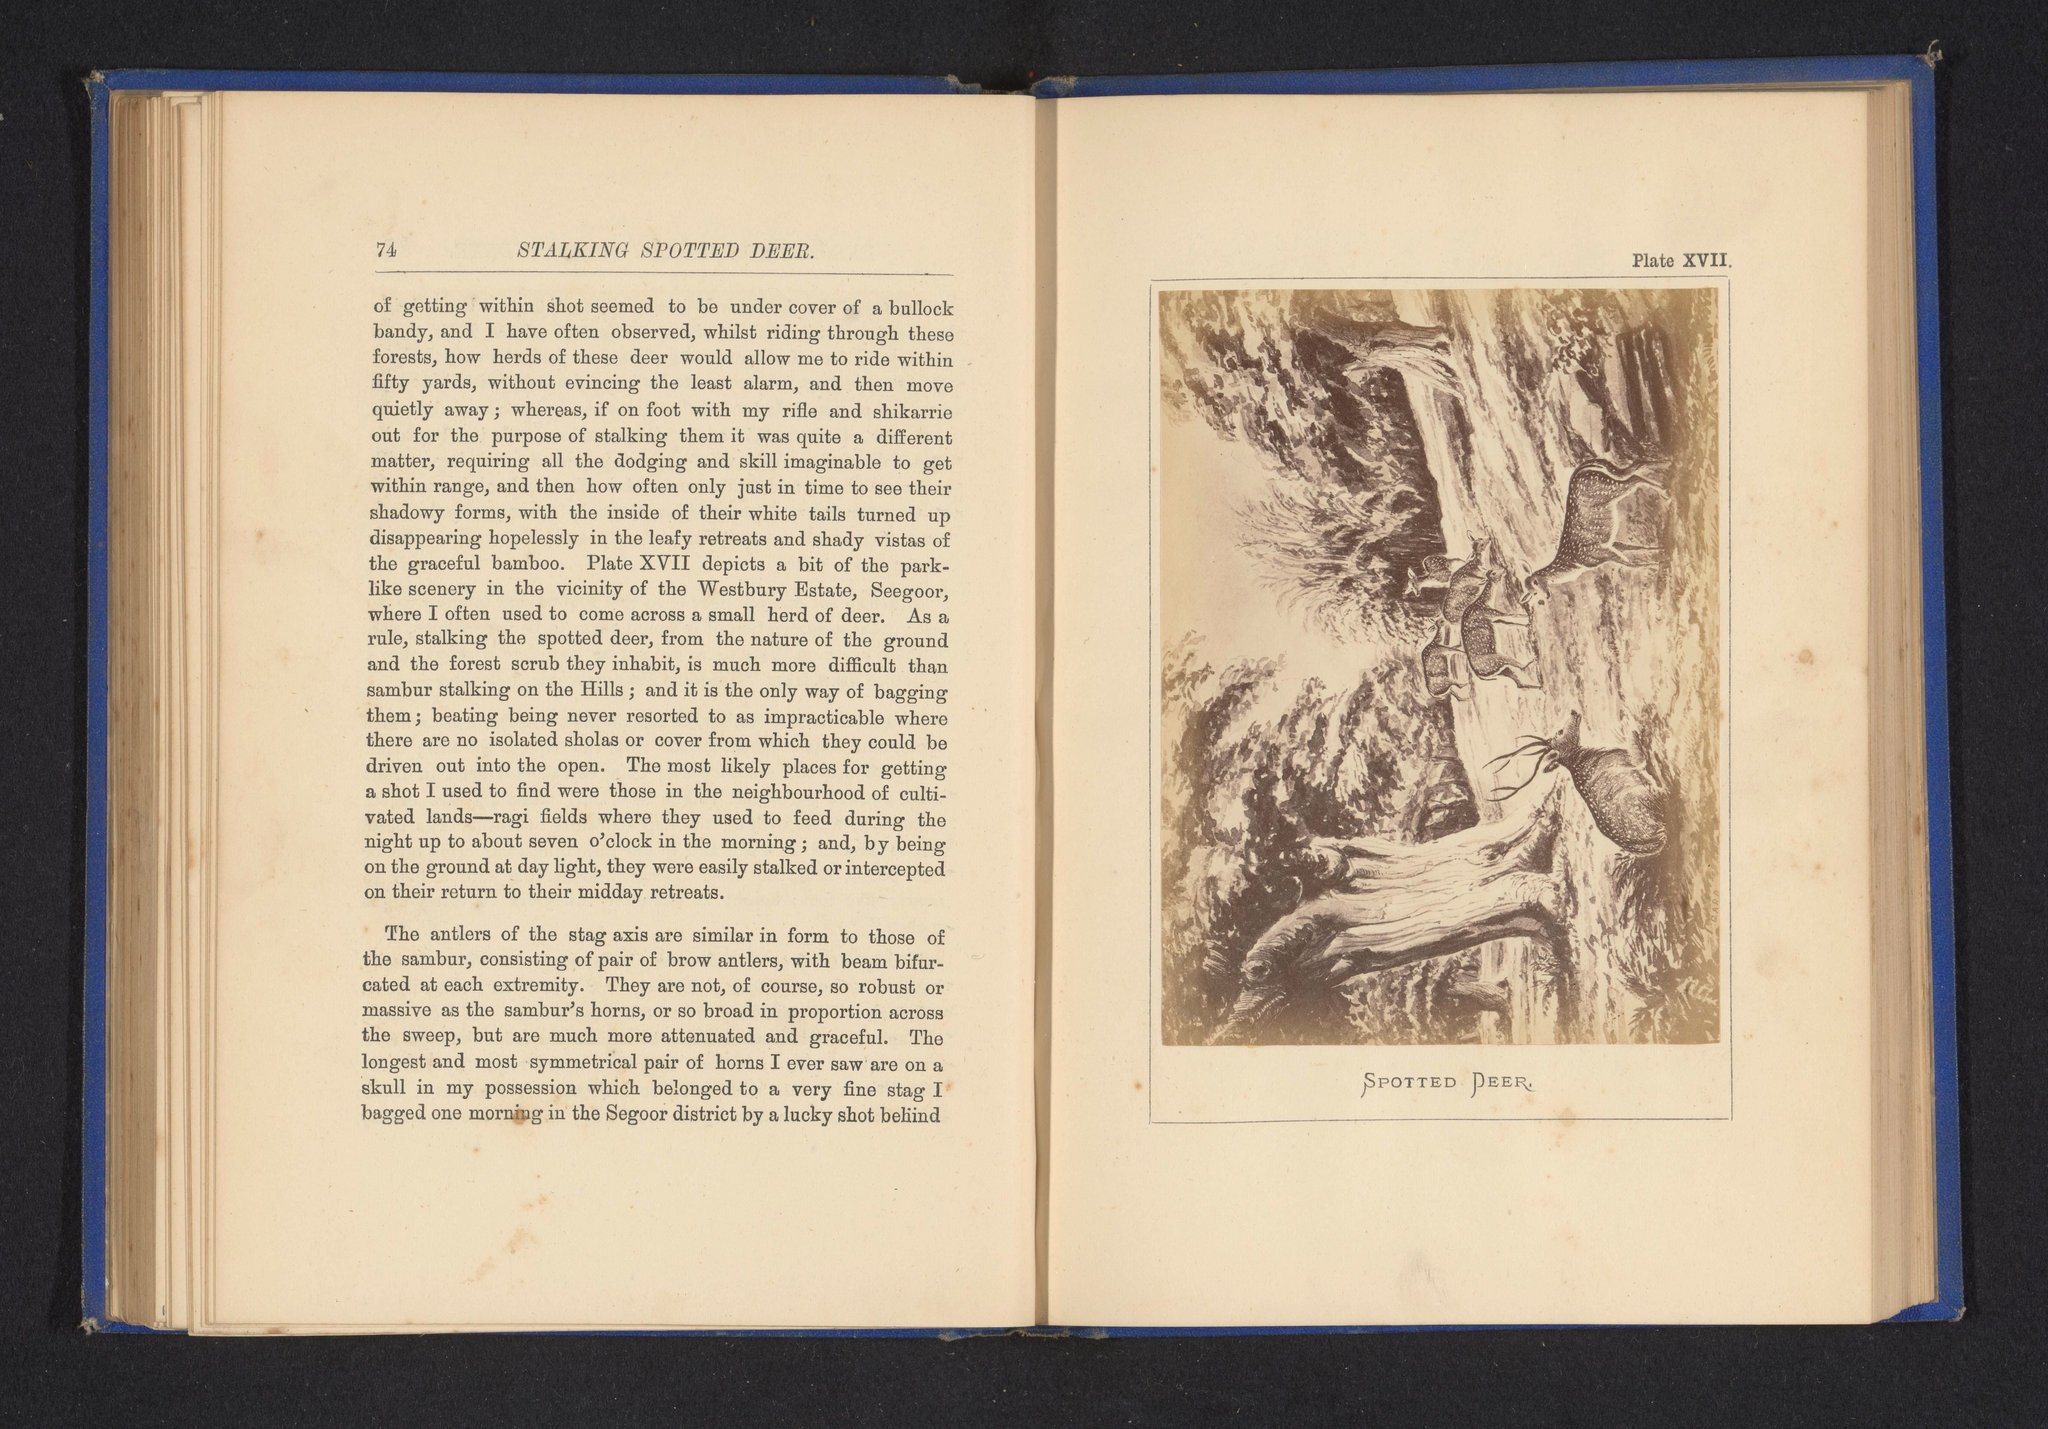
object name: photograph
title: Fotoreproductie van een tekening van een roedel axisherten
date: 1870-1880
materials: photographic support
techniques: albumen print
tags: drawing, sketch, hoofed animals: deer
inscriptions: number: ‘Plate XVII.’